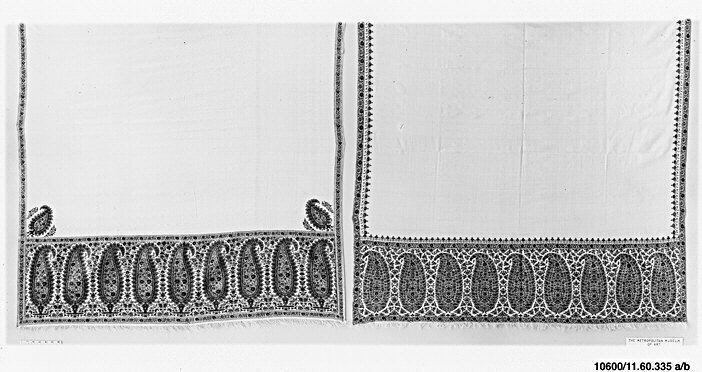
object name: shawl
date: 1801-1900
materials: wool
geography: india